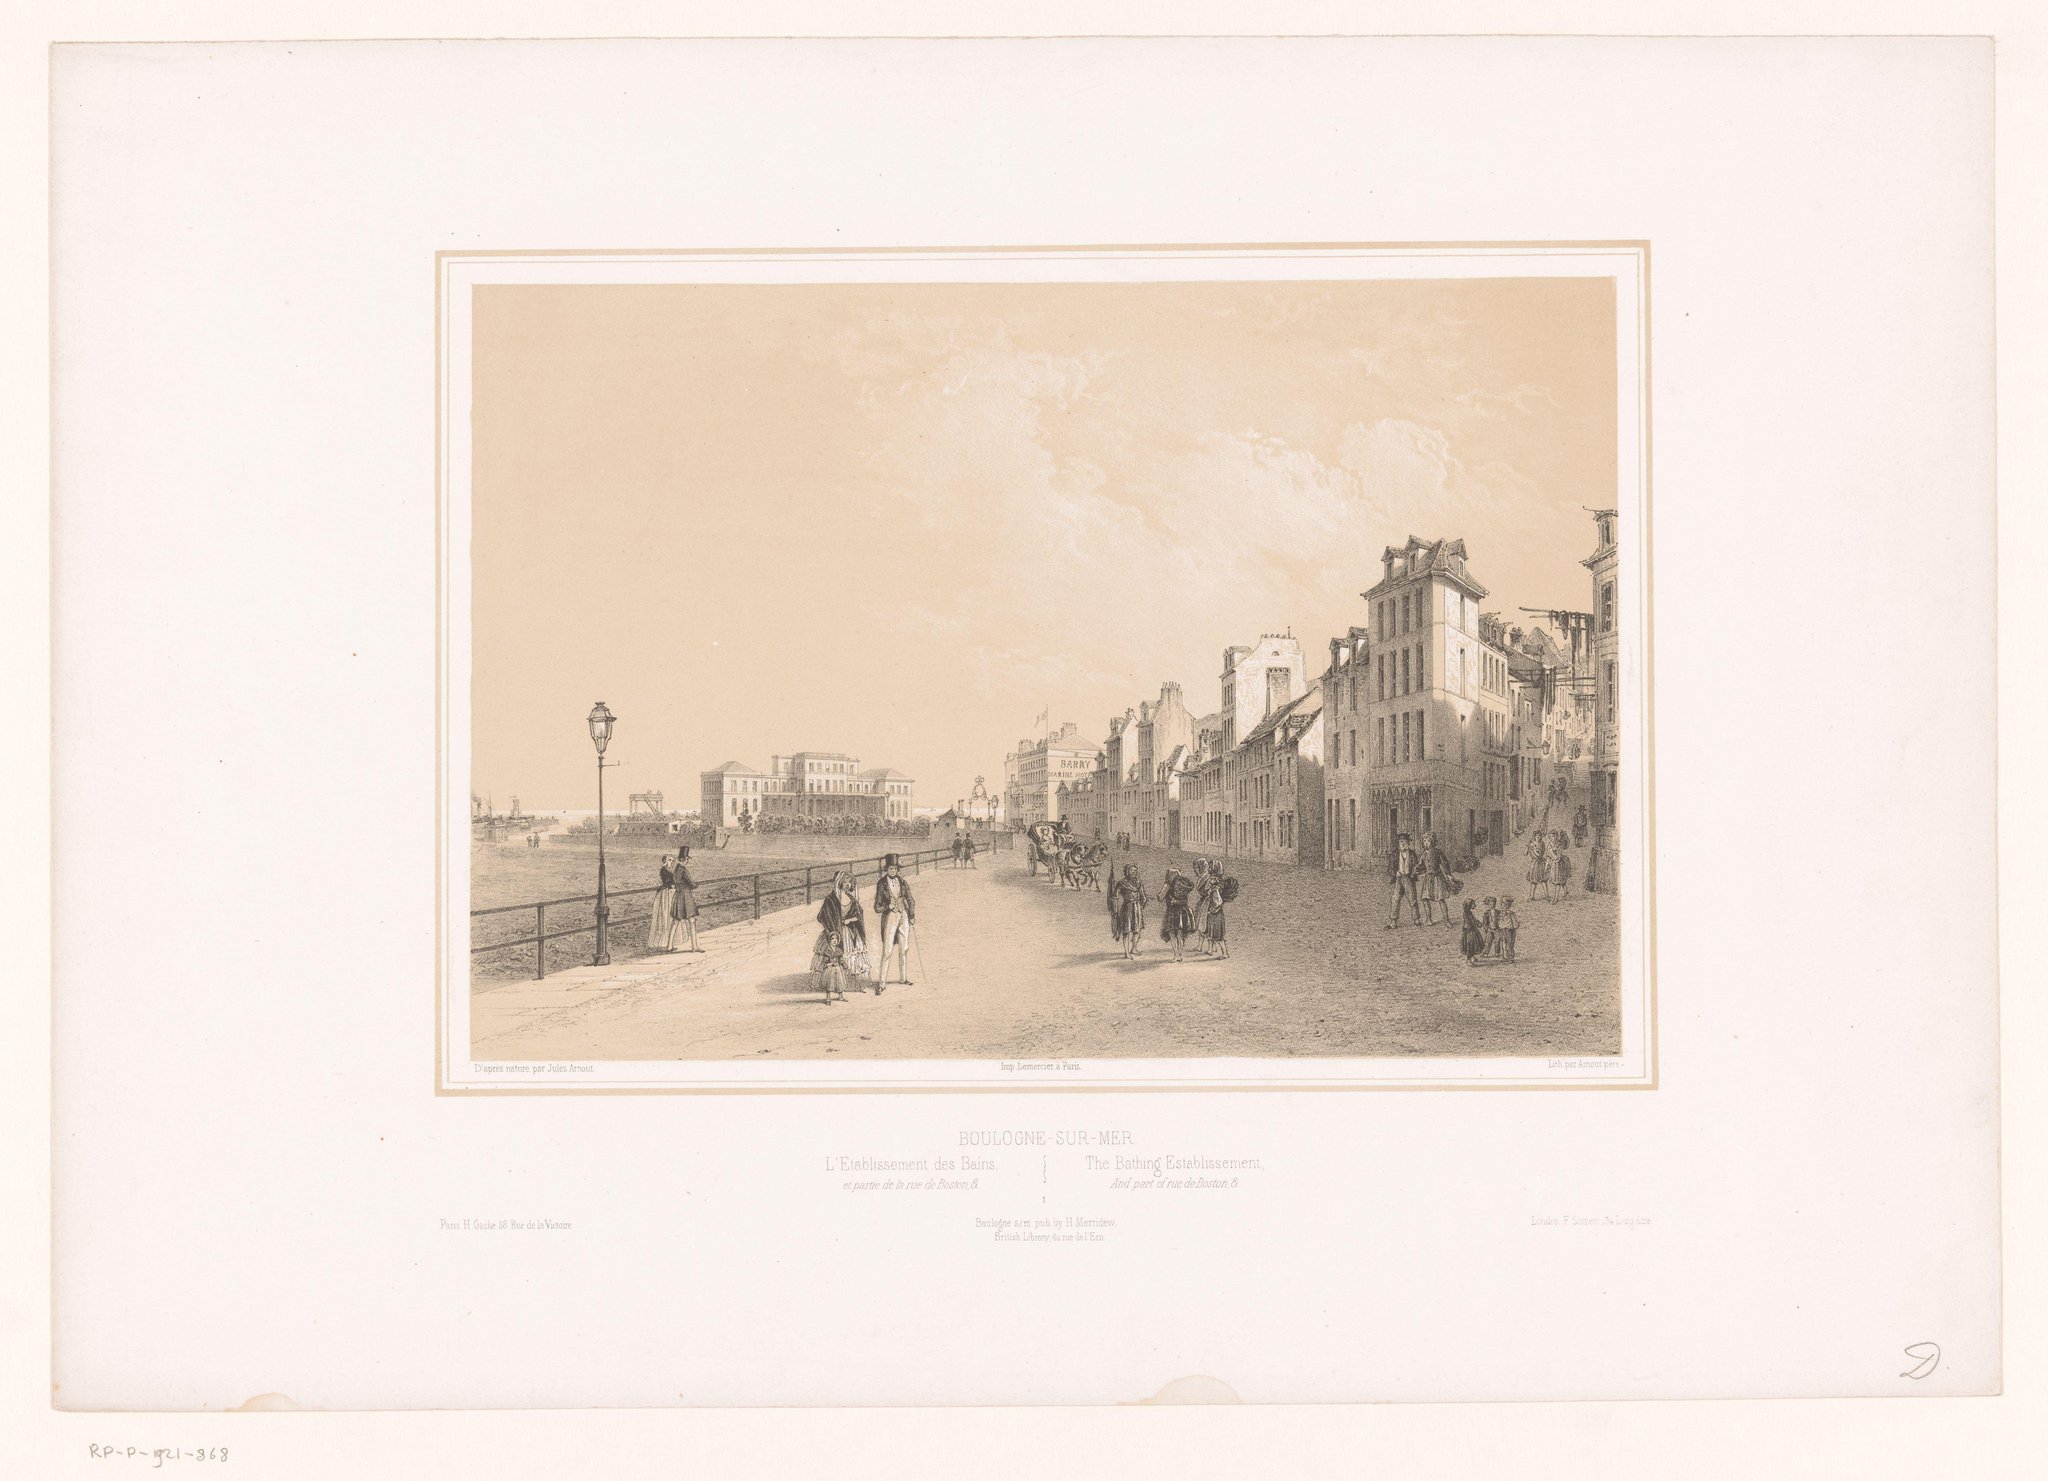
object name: print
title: L'Etablissement des Bains / The Bathing Etablissement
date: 1847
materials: paper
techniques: tone lithography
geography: paris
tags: public baths, open-air recreation, avenue, boulevard, promenade, esplanade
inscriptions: collector's mark: Lugt 2228, check stamp: Lugt 3977, collector's mark: Lugt 2233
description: Wandelaars flaneren over de boulevard langs de zee. Op de achtergrond is het badencomplex te zien.